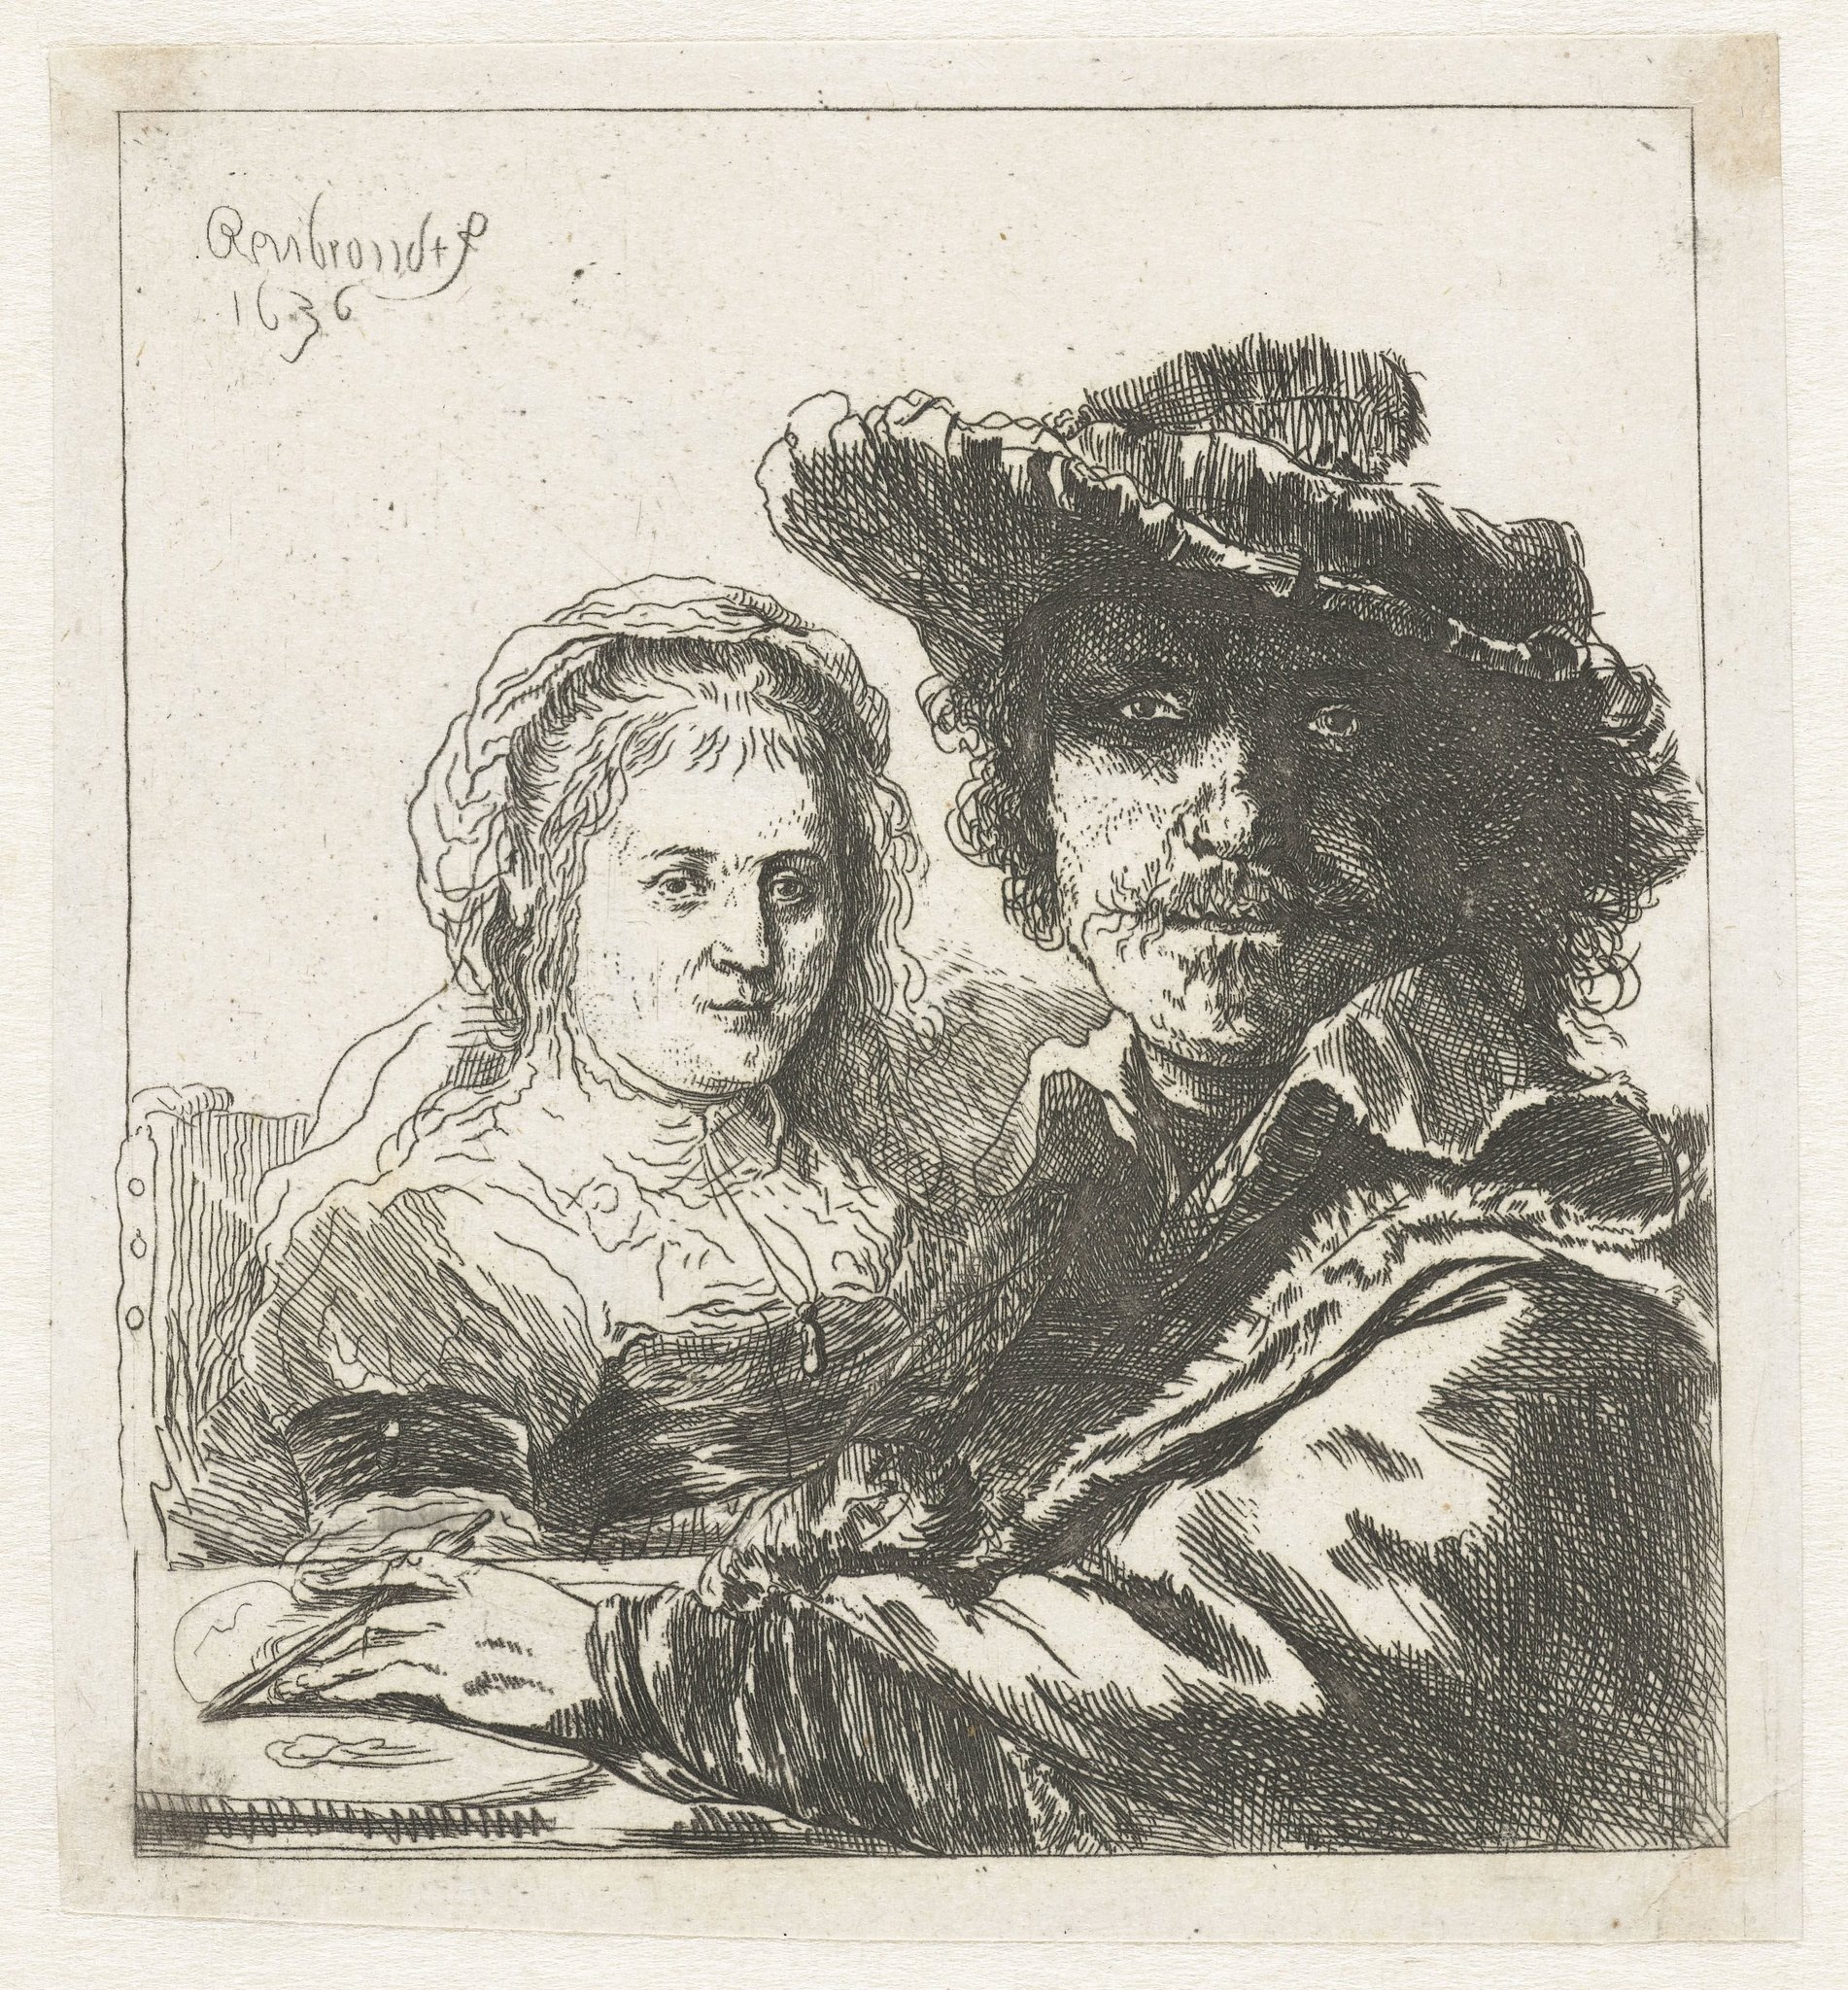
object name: print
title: Self-portrait with Saskia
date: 1805-1844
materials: paper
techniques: etching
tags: amsterdam, painter, print maker, draughtsman, rembrandt van rijn, historical persons - bb - woman, portrait, self-portrait of graphic artist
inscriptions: collector's mark: Lugt 2760, collector's mark: Lugt 2228